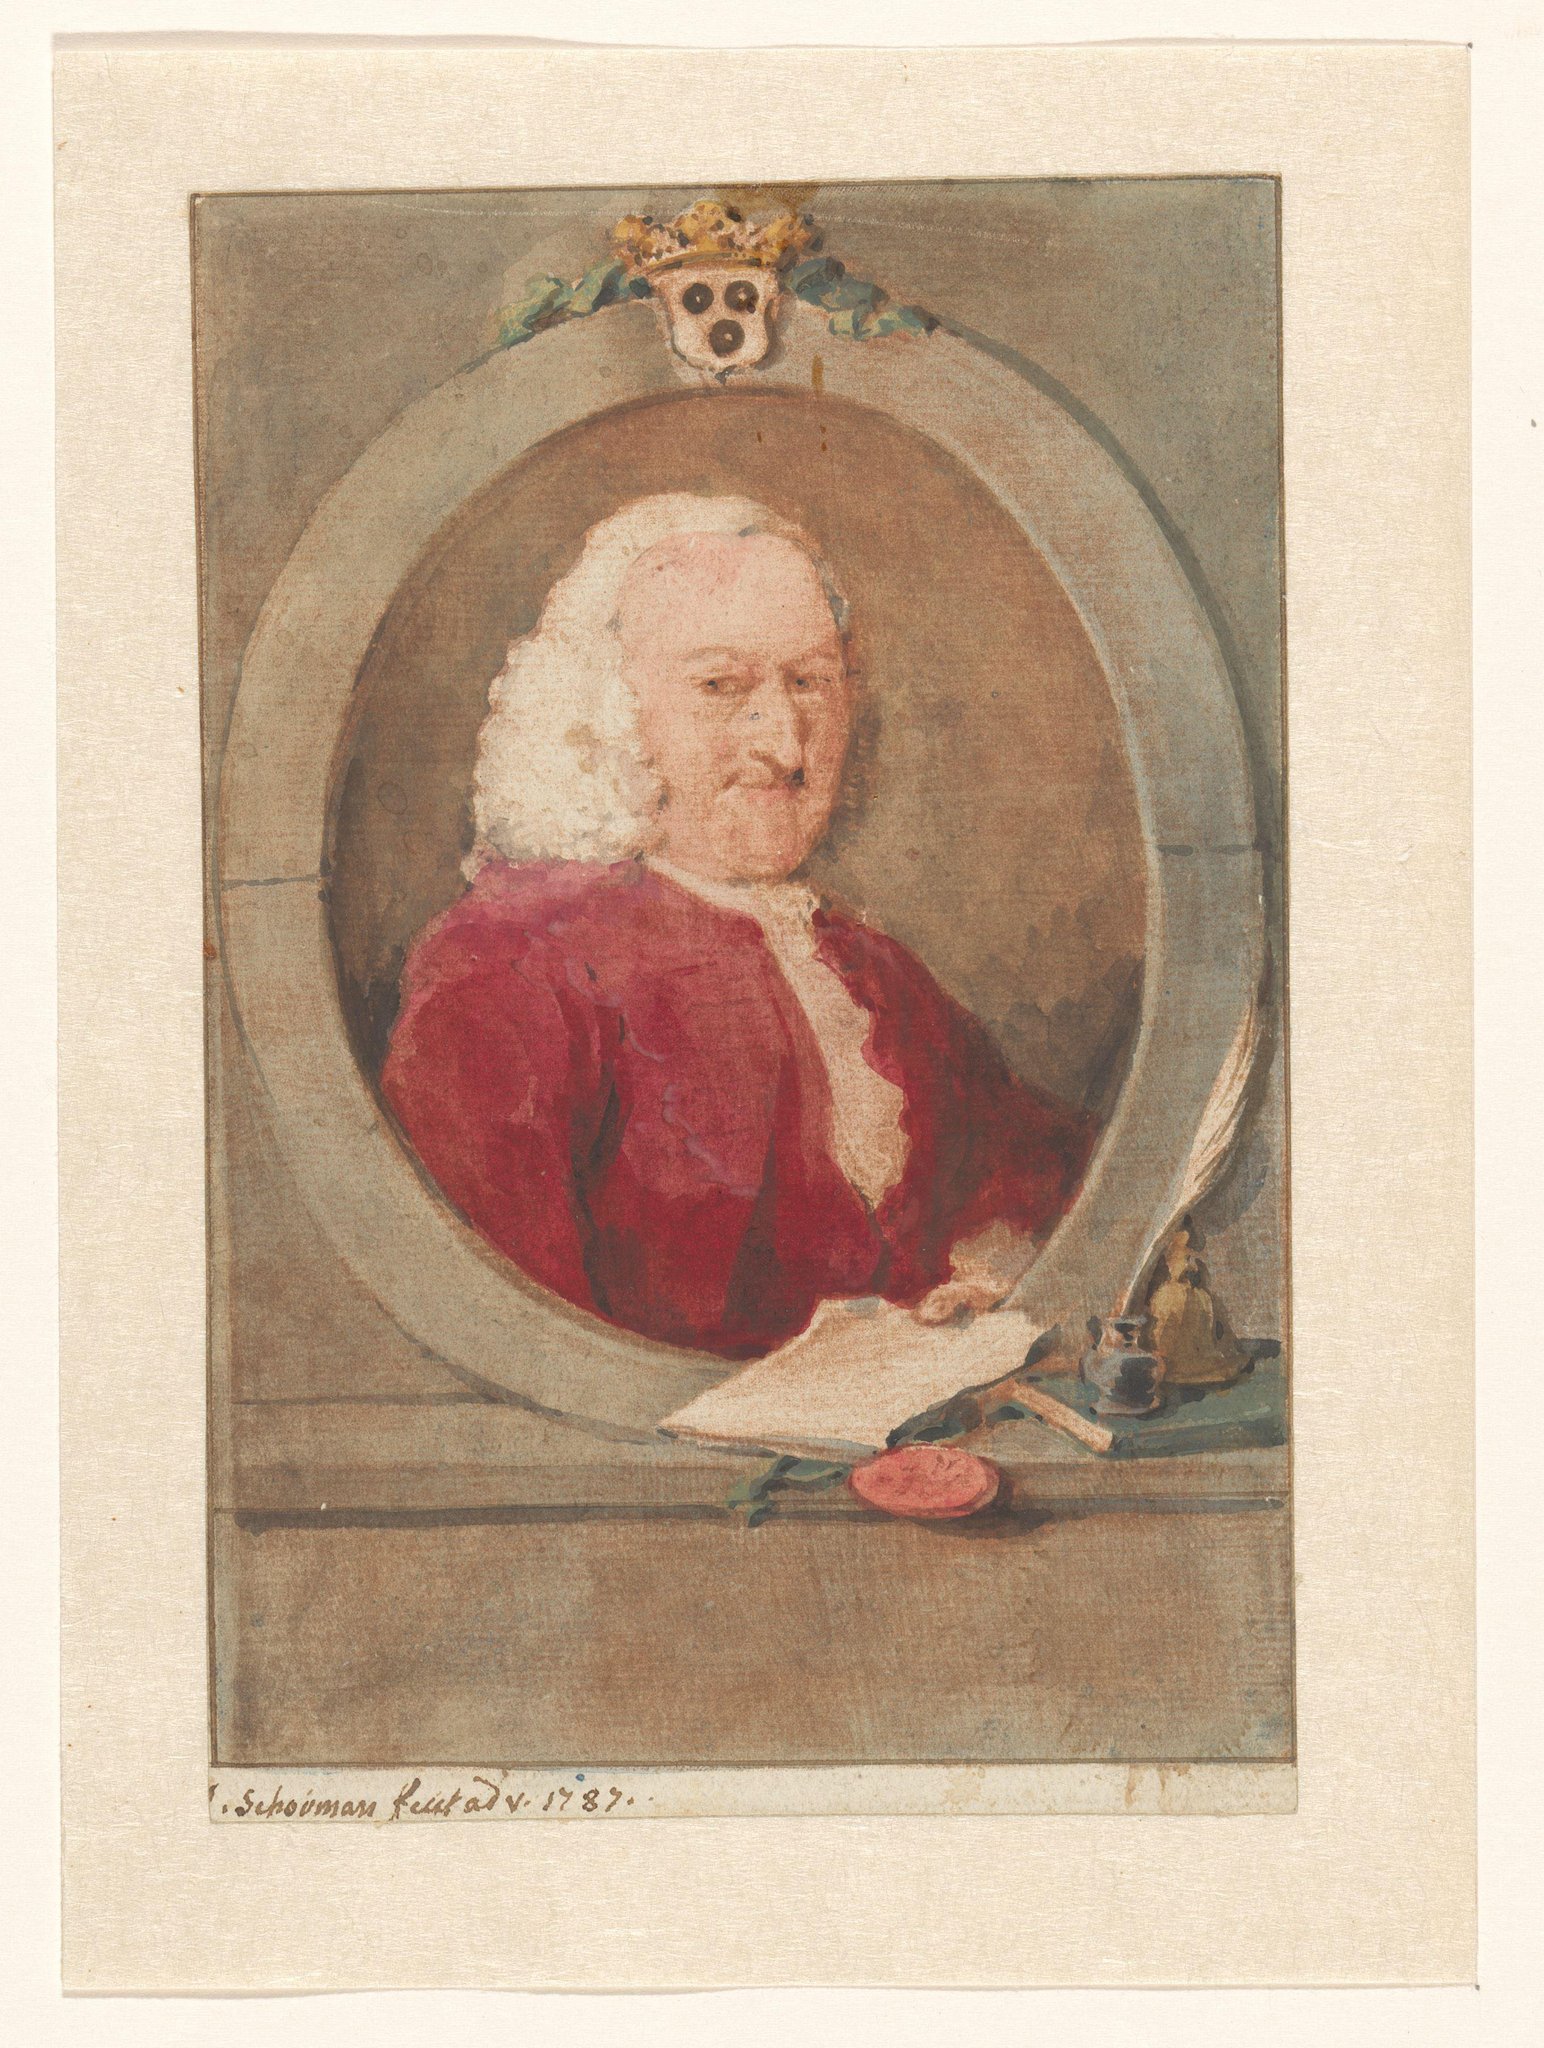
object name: drawing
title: Portret van Pieter van Bleiswijk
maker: aert schouman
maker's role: draughtsman, painter, print maker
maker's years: 1710-1792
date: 1787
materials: paper, watercolor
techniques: brush, printmaking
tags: delft, the hague, historical persons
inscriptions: date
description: Portret van Pieter van Bleiswijk (1724-1790), raadpensionaris van Holland.